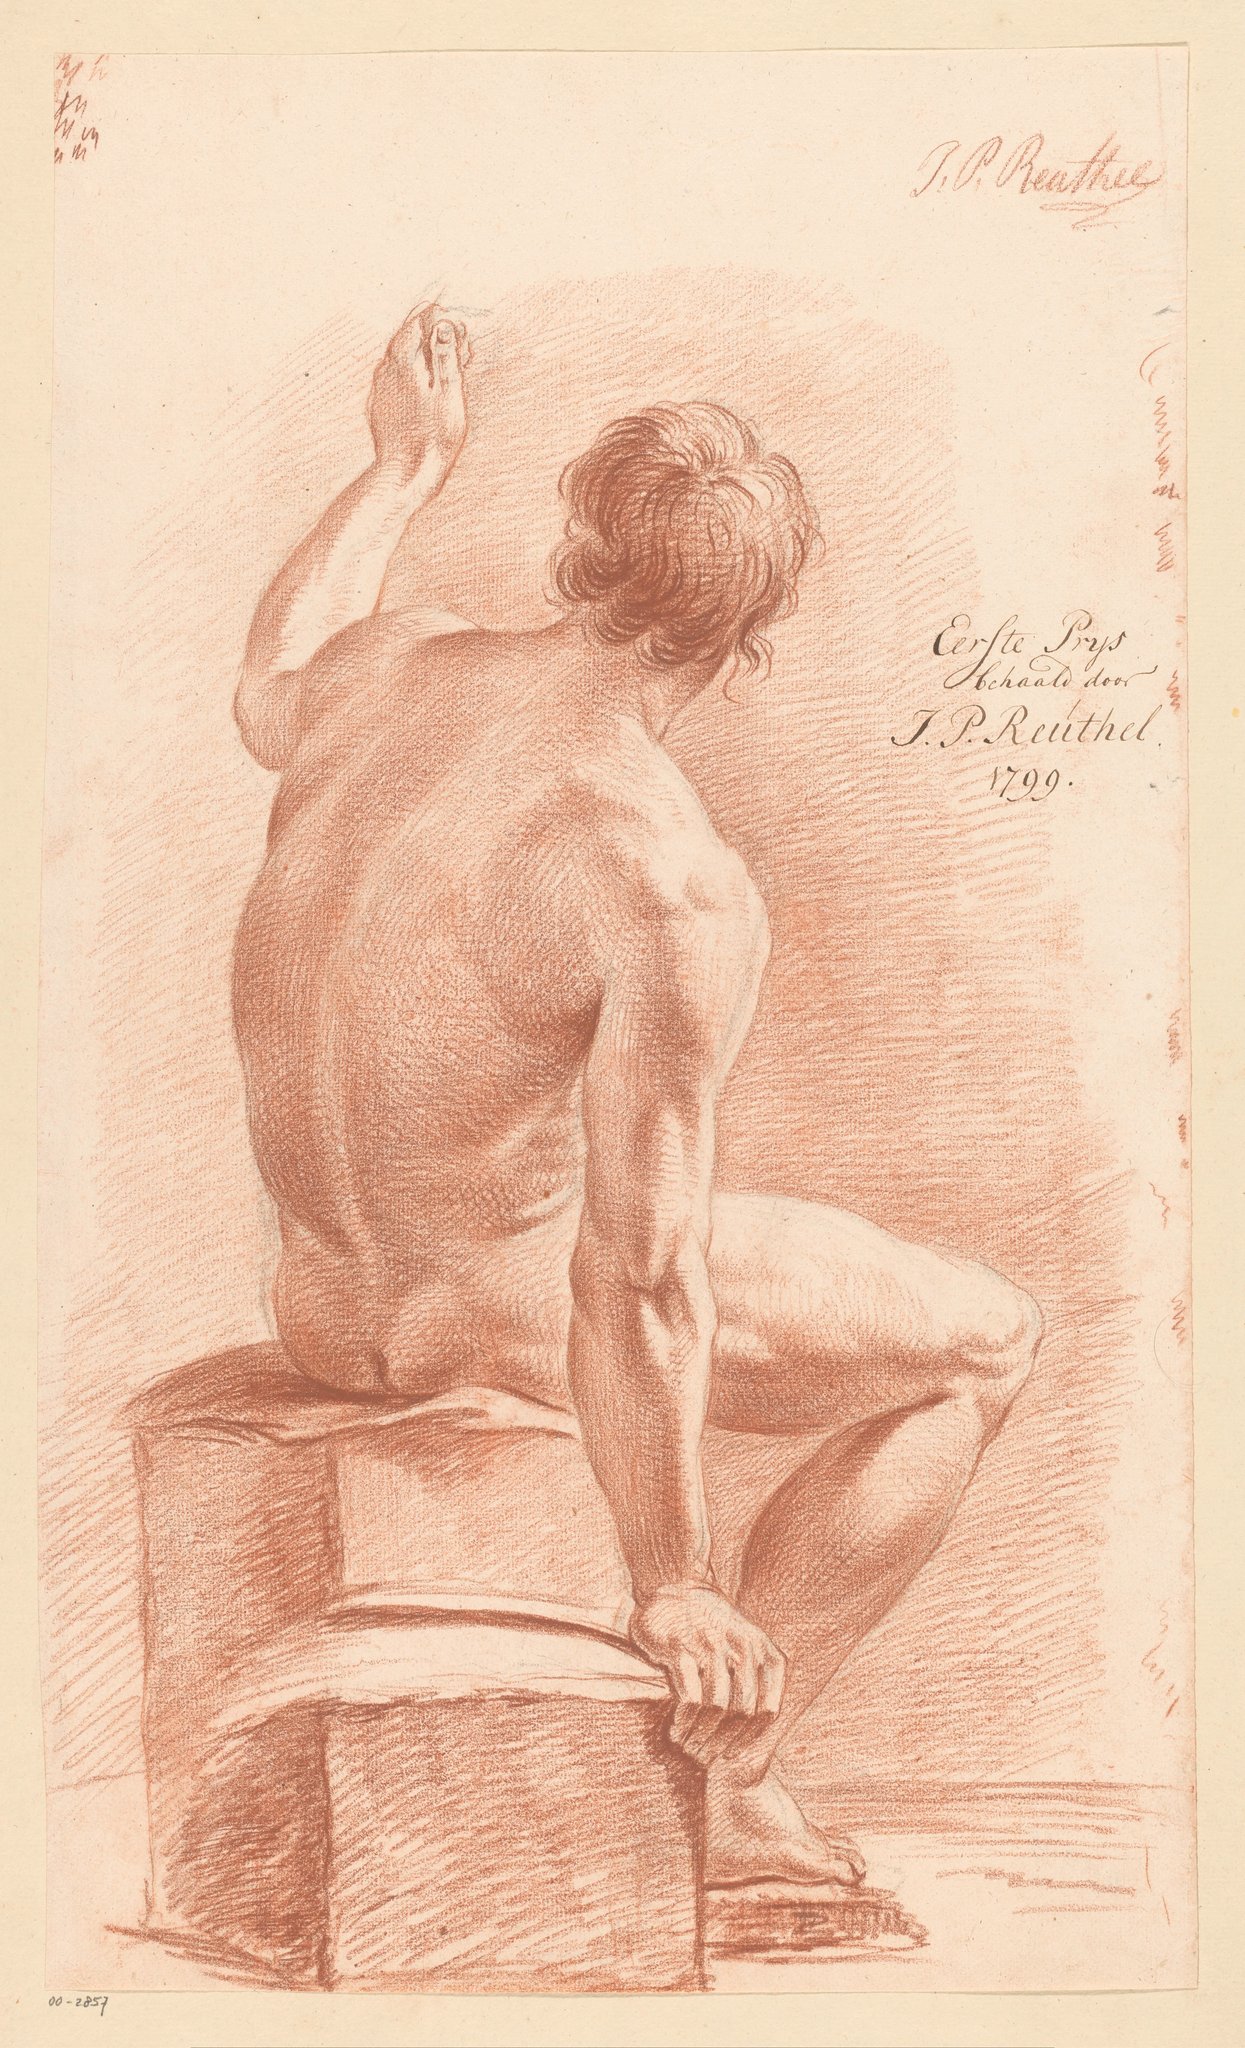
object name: drawing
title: Zittend mannelijk naakt, op de rug gezien (1e prijs 1799)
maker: jan philip reuthel jr.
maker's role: draughtsman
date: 1799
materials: chalk, charcoal, paper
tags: sitting figure (+ nude human being)